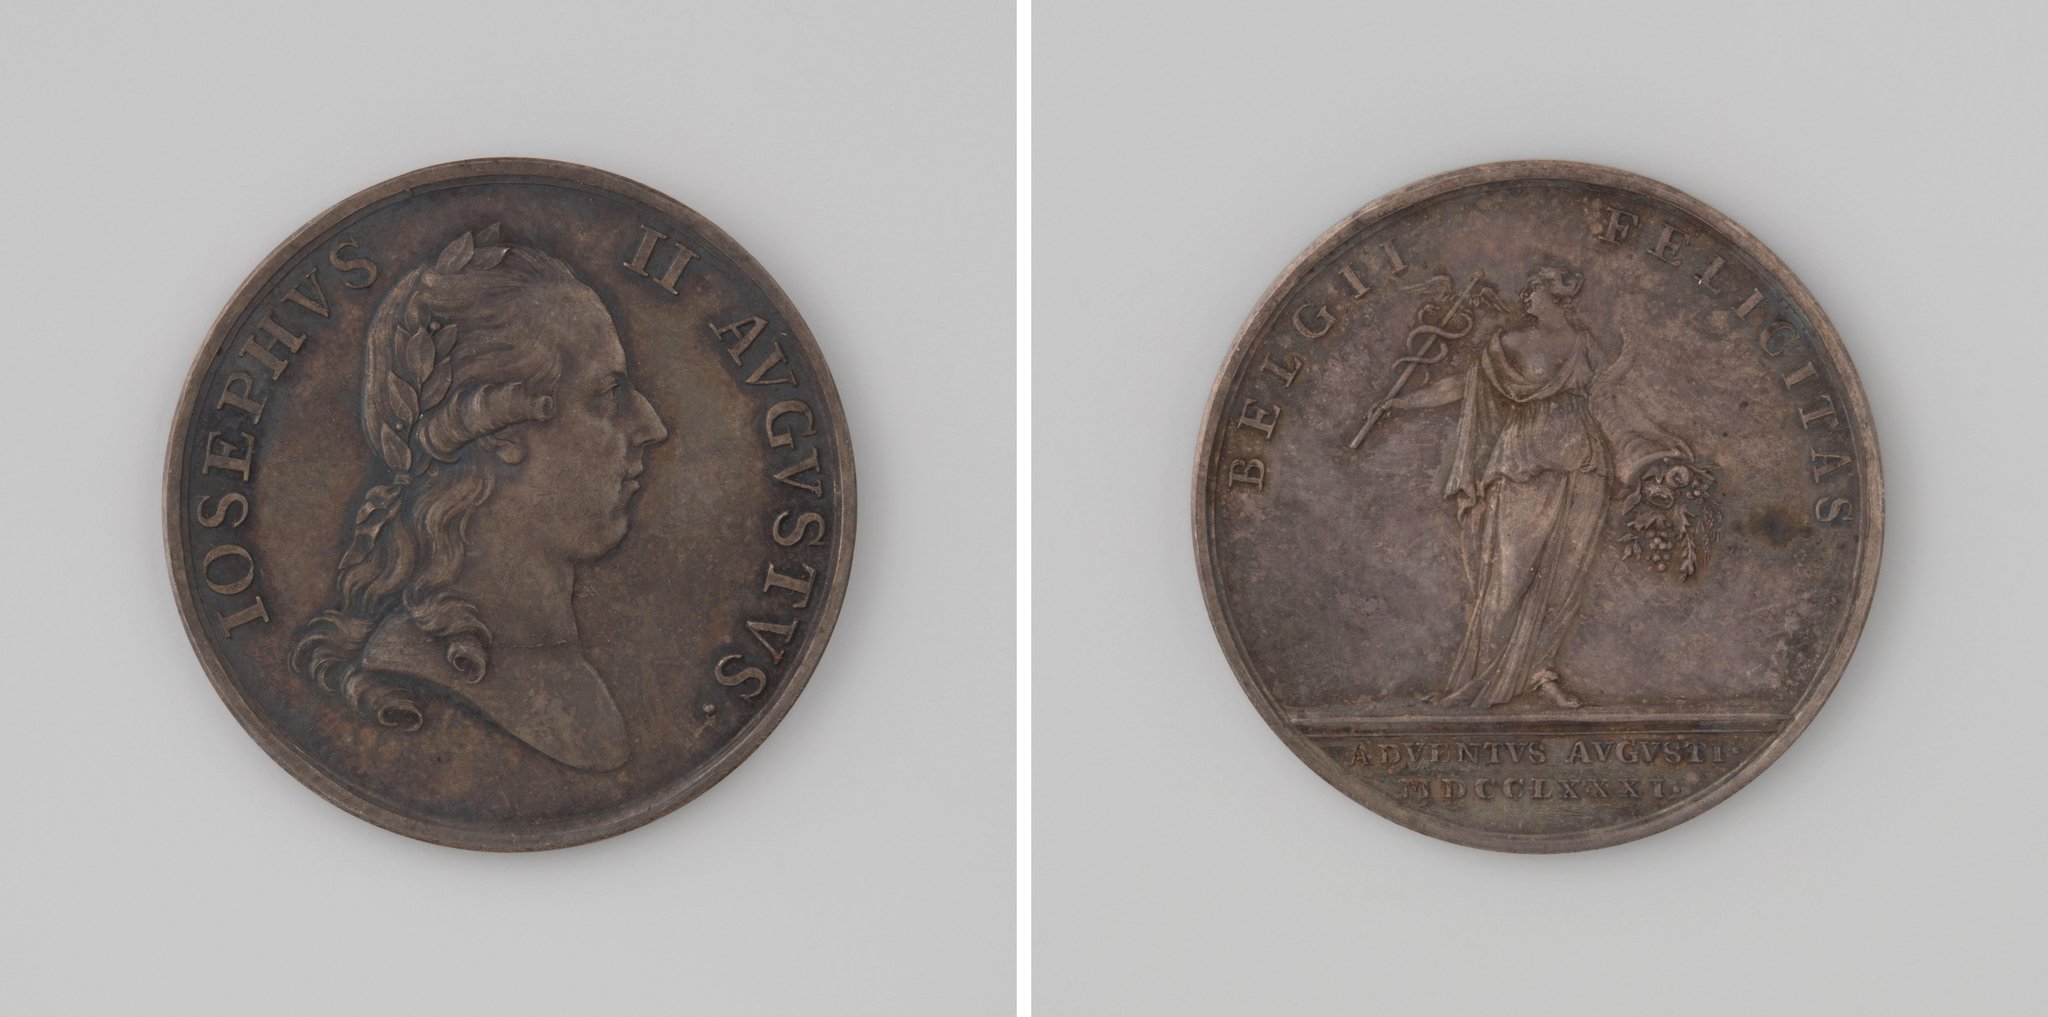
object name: history medal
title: Aankomst van Jozef II, Duits keizer in de Oostenrijkse Nederlanden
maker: theodorus victor van berckel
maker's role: mintmaster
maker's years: 1739-1808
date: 1781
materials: silver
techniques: striking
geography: brussels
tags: vienna, jozef ii (duits keizer), belgium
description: Zilveren penning. Voorzijde: borststuk man met lauwerkrans binnen omschrift. Keerzijde: vrouw met Mercuriusstaf en gevulde hoorn van overvloed, voorstellende Belgie binnen omschrift; afsnede: opschrift